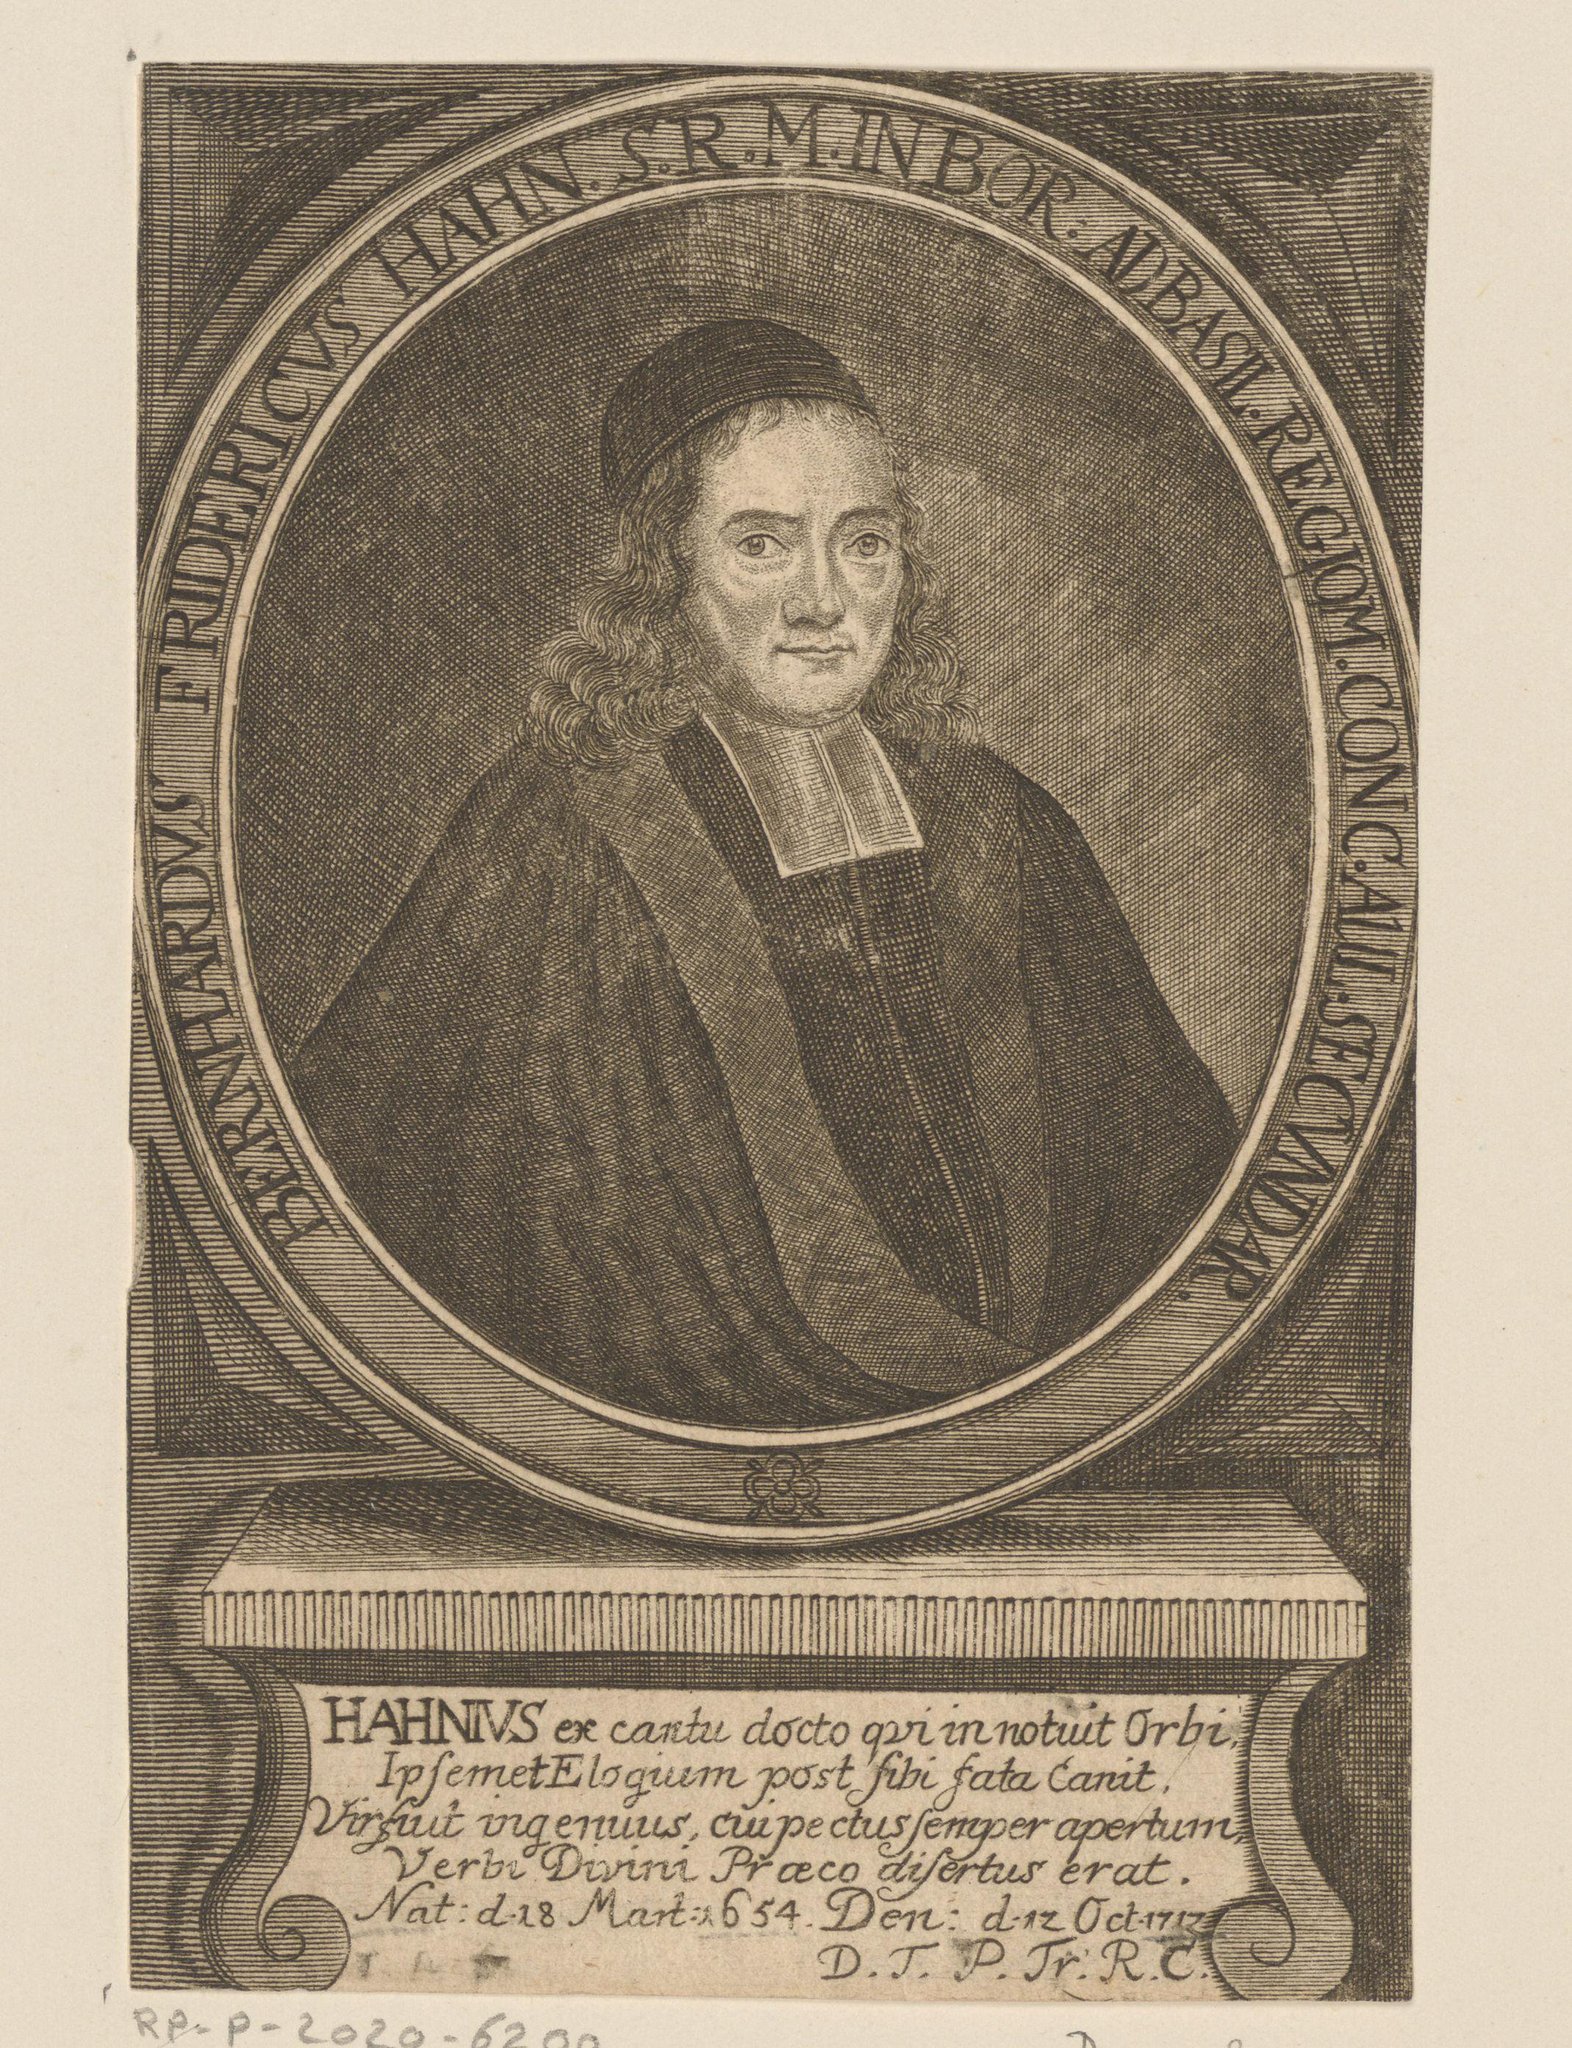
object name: print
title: Portret van Bernhard Friedrich Hahn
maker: Anonymous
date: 1717-1749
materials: paper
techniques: engraving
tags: historical persons